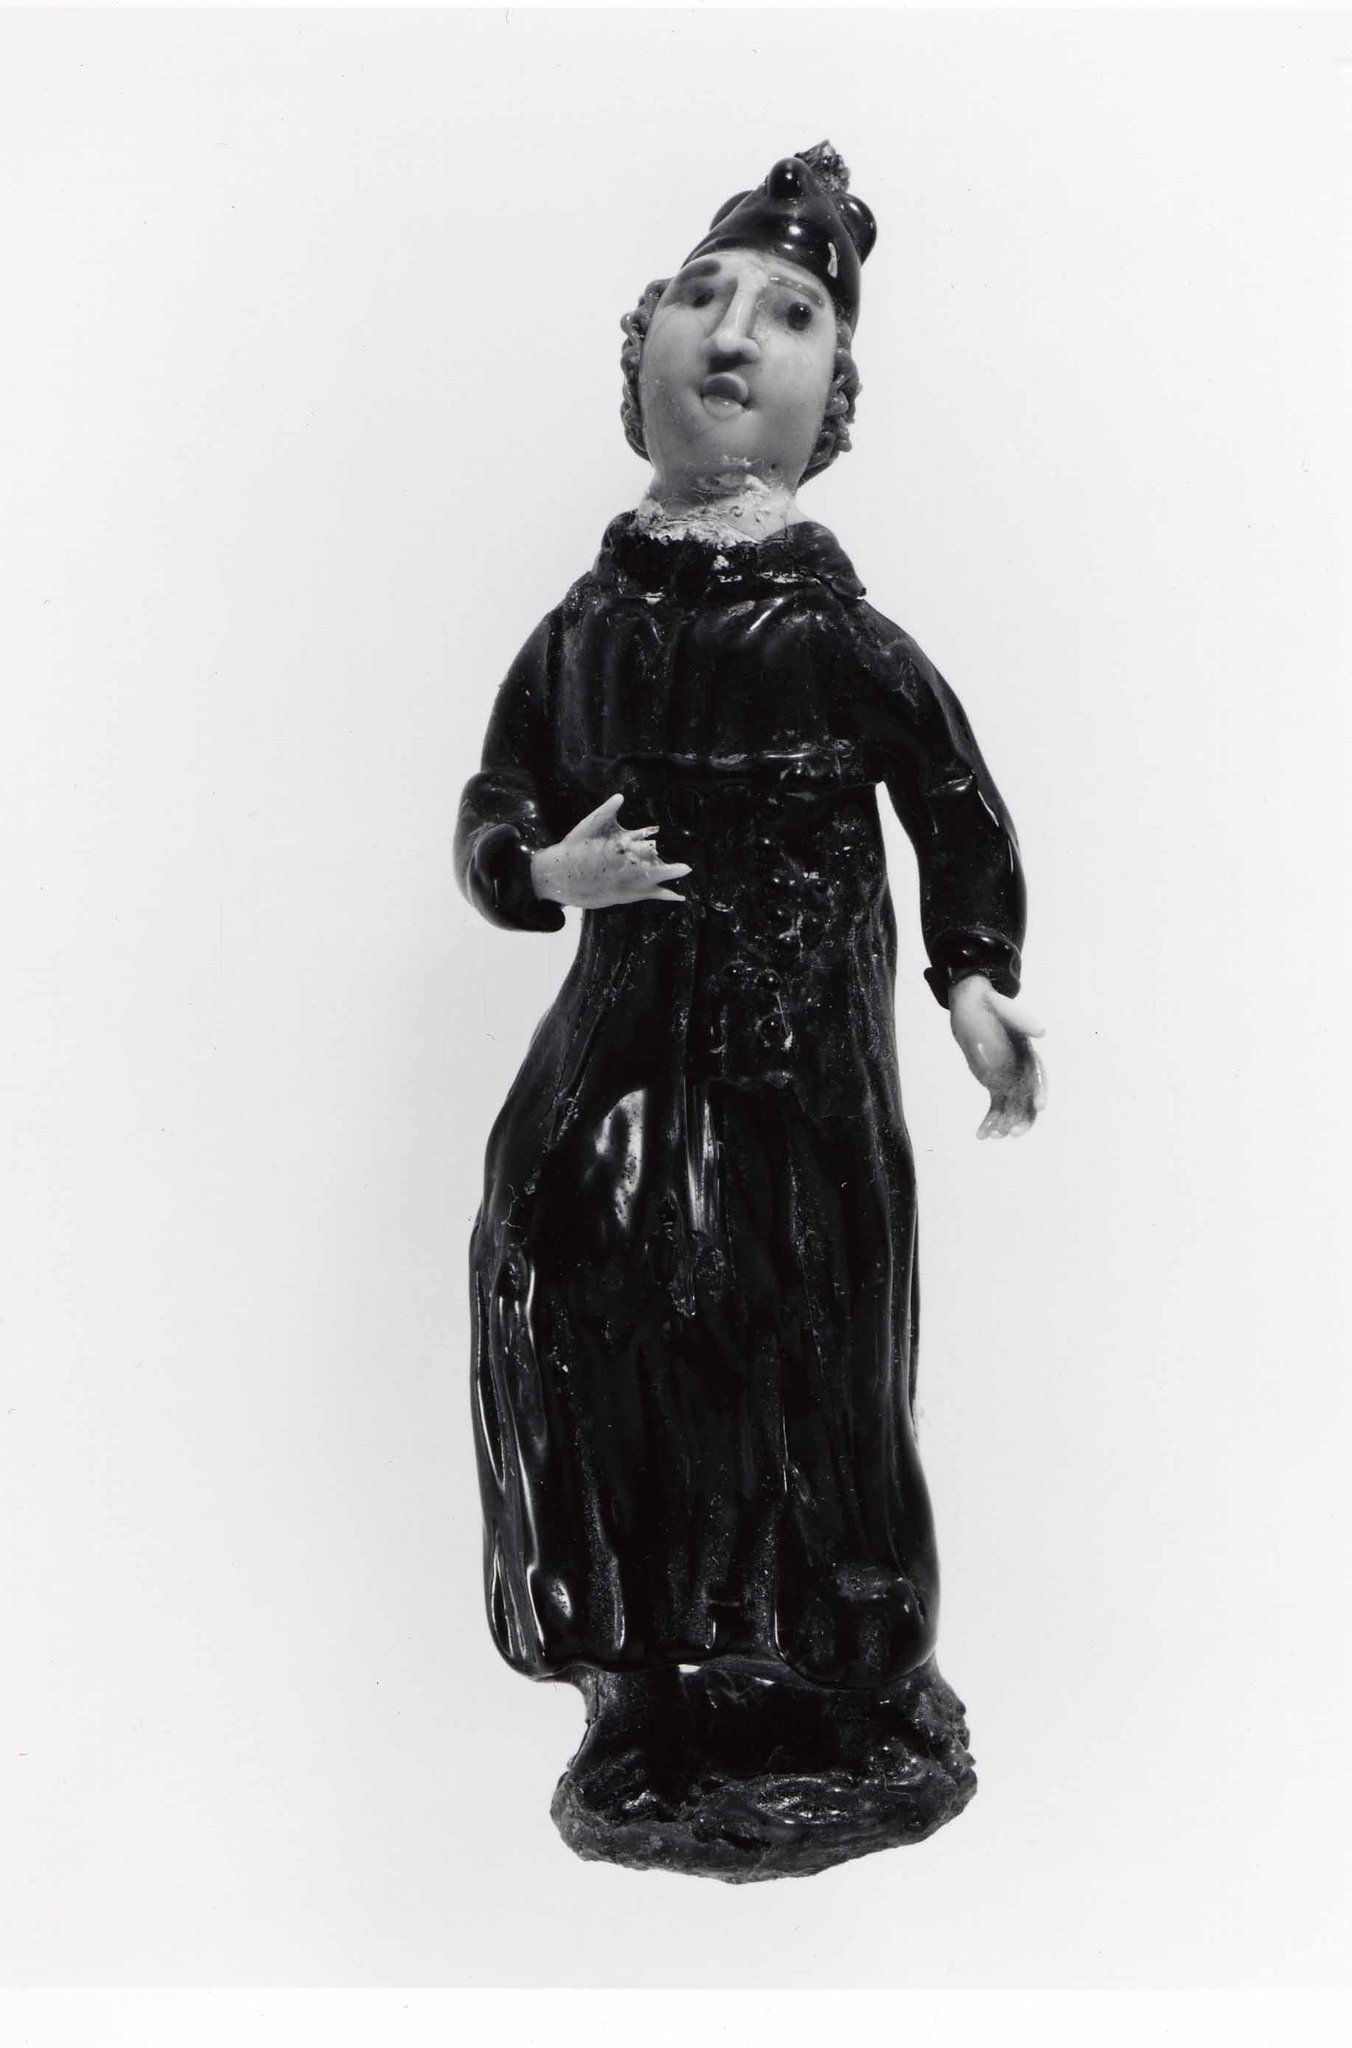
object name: figurine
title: A Prelate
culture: french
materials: gemstone, copper, glass, lead, metal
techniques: lampwork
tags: men